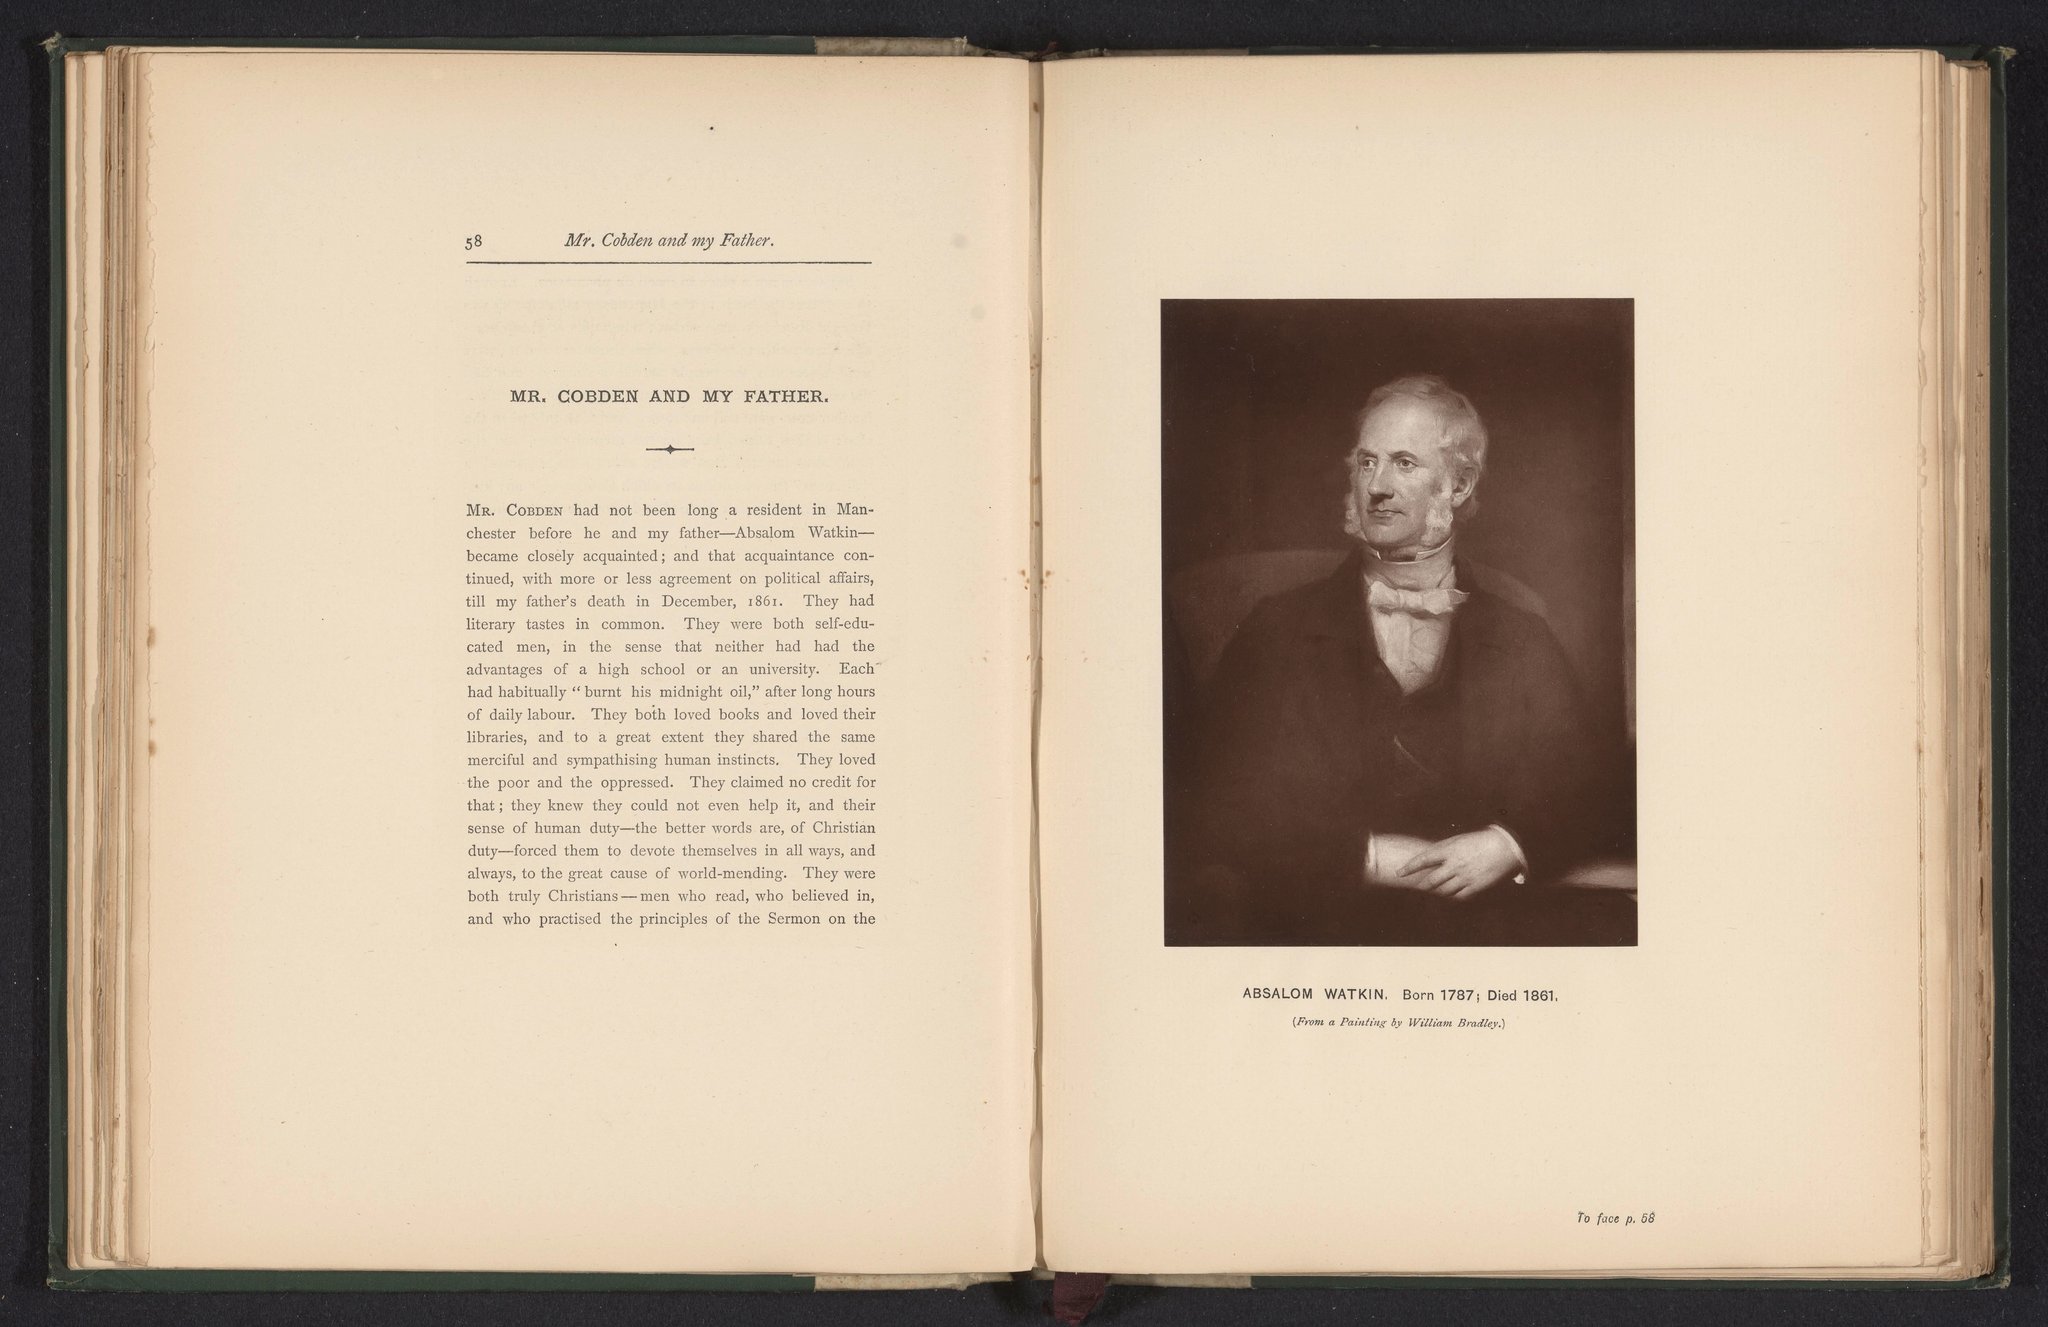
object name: page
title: Absalom Watkin, Born 1787; Died 1861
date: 1881-1891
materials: paper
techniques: woodburytype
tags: politician, politician, e.g. party leader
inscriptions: inscription: ‘(From a Painting by William Bradley.)’